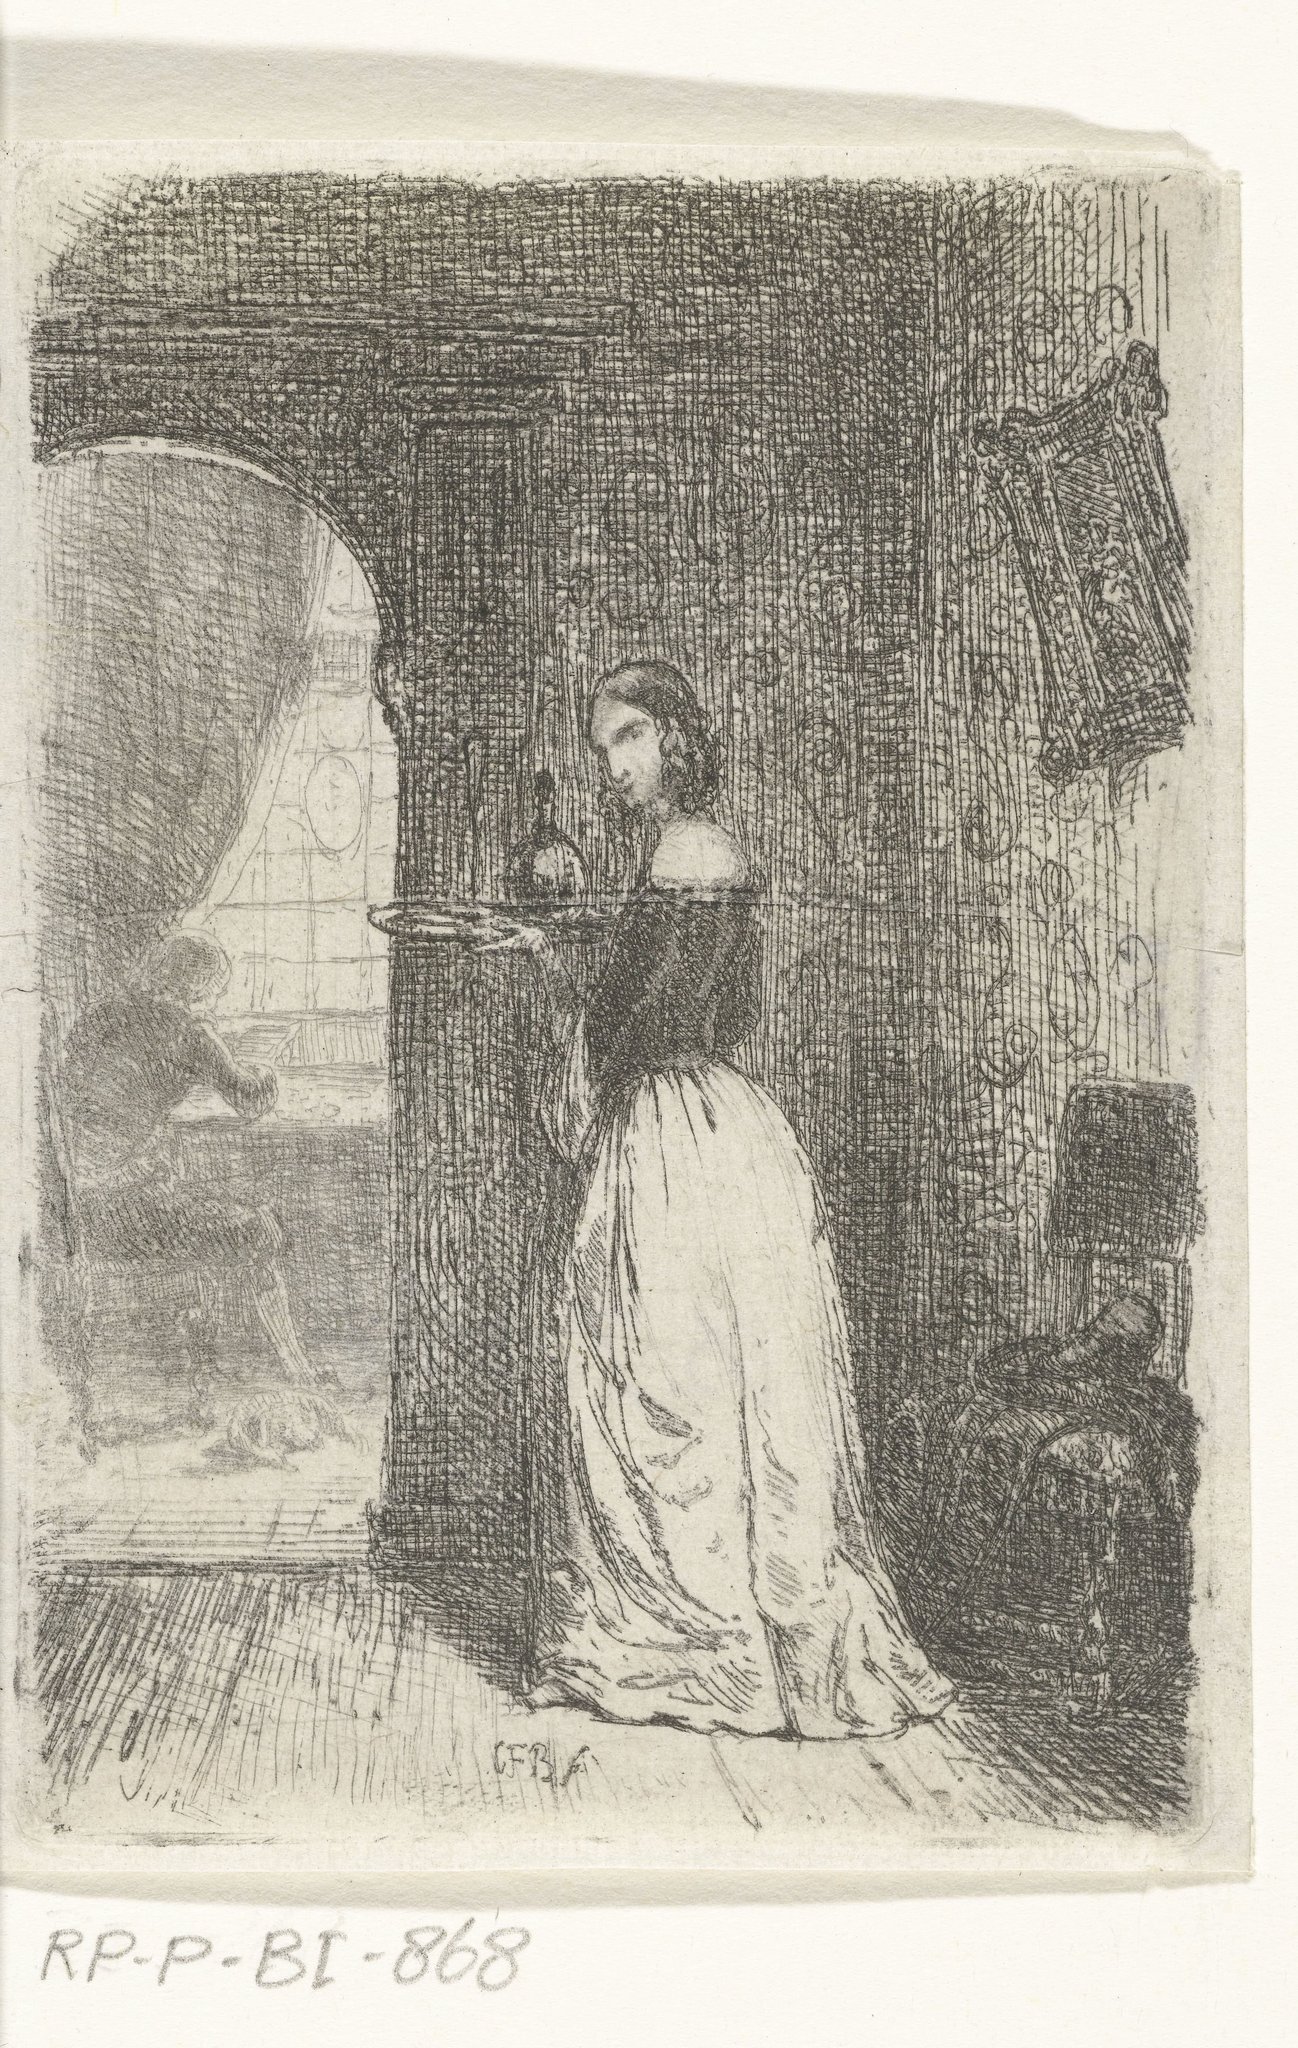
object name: print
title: Interieur met vrouw met dienblad en man aan tafel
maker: carel frederik bendorp (ii)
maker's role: draughtsman, painter, print maker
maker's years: 1819-1897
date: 1829-1897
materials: paper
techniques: etching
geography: netherlands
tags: family life at home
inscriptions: collector's mark: Lugt 2228